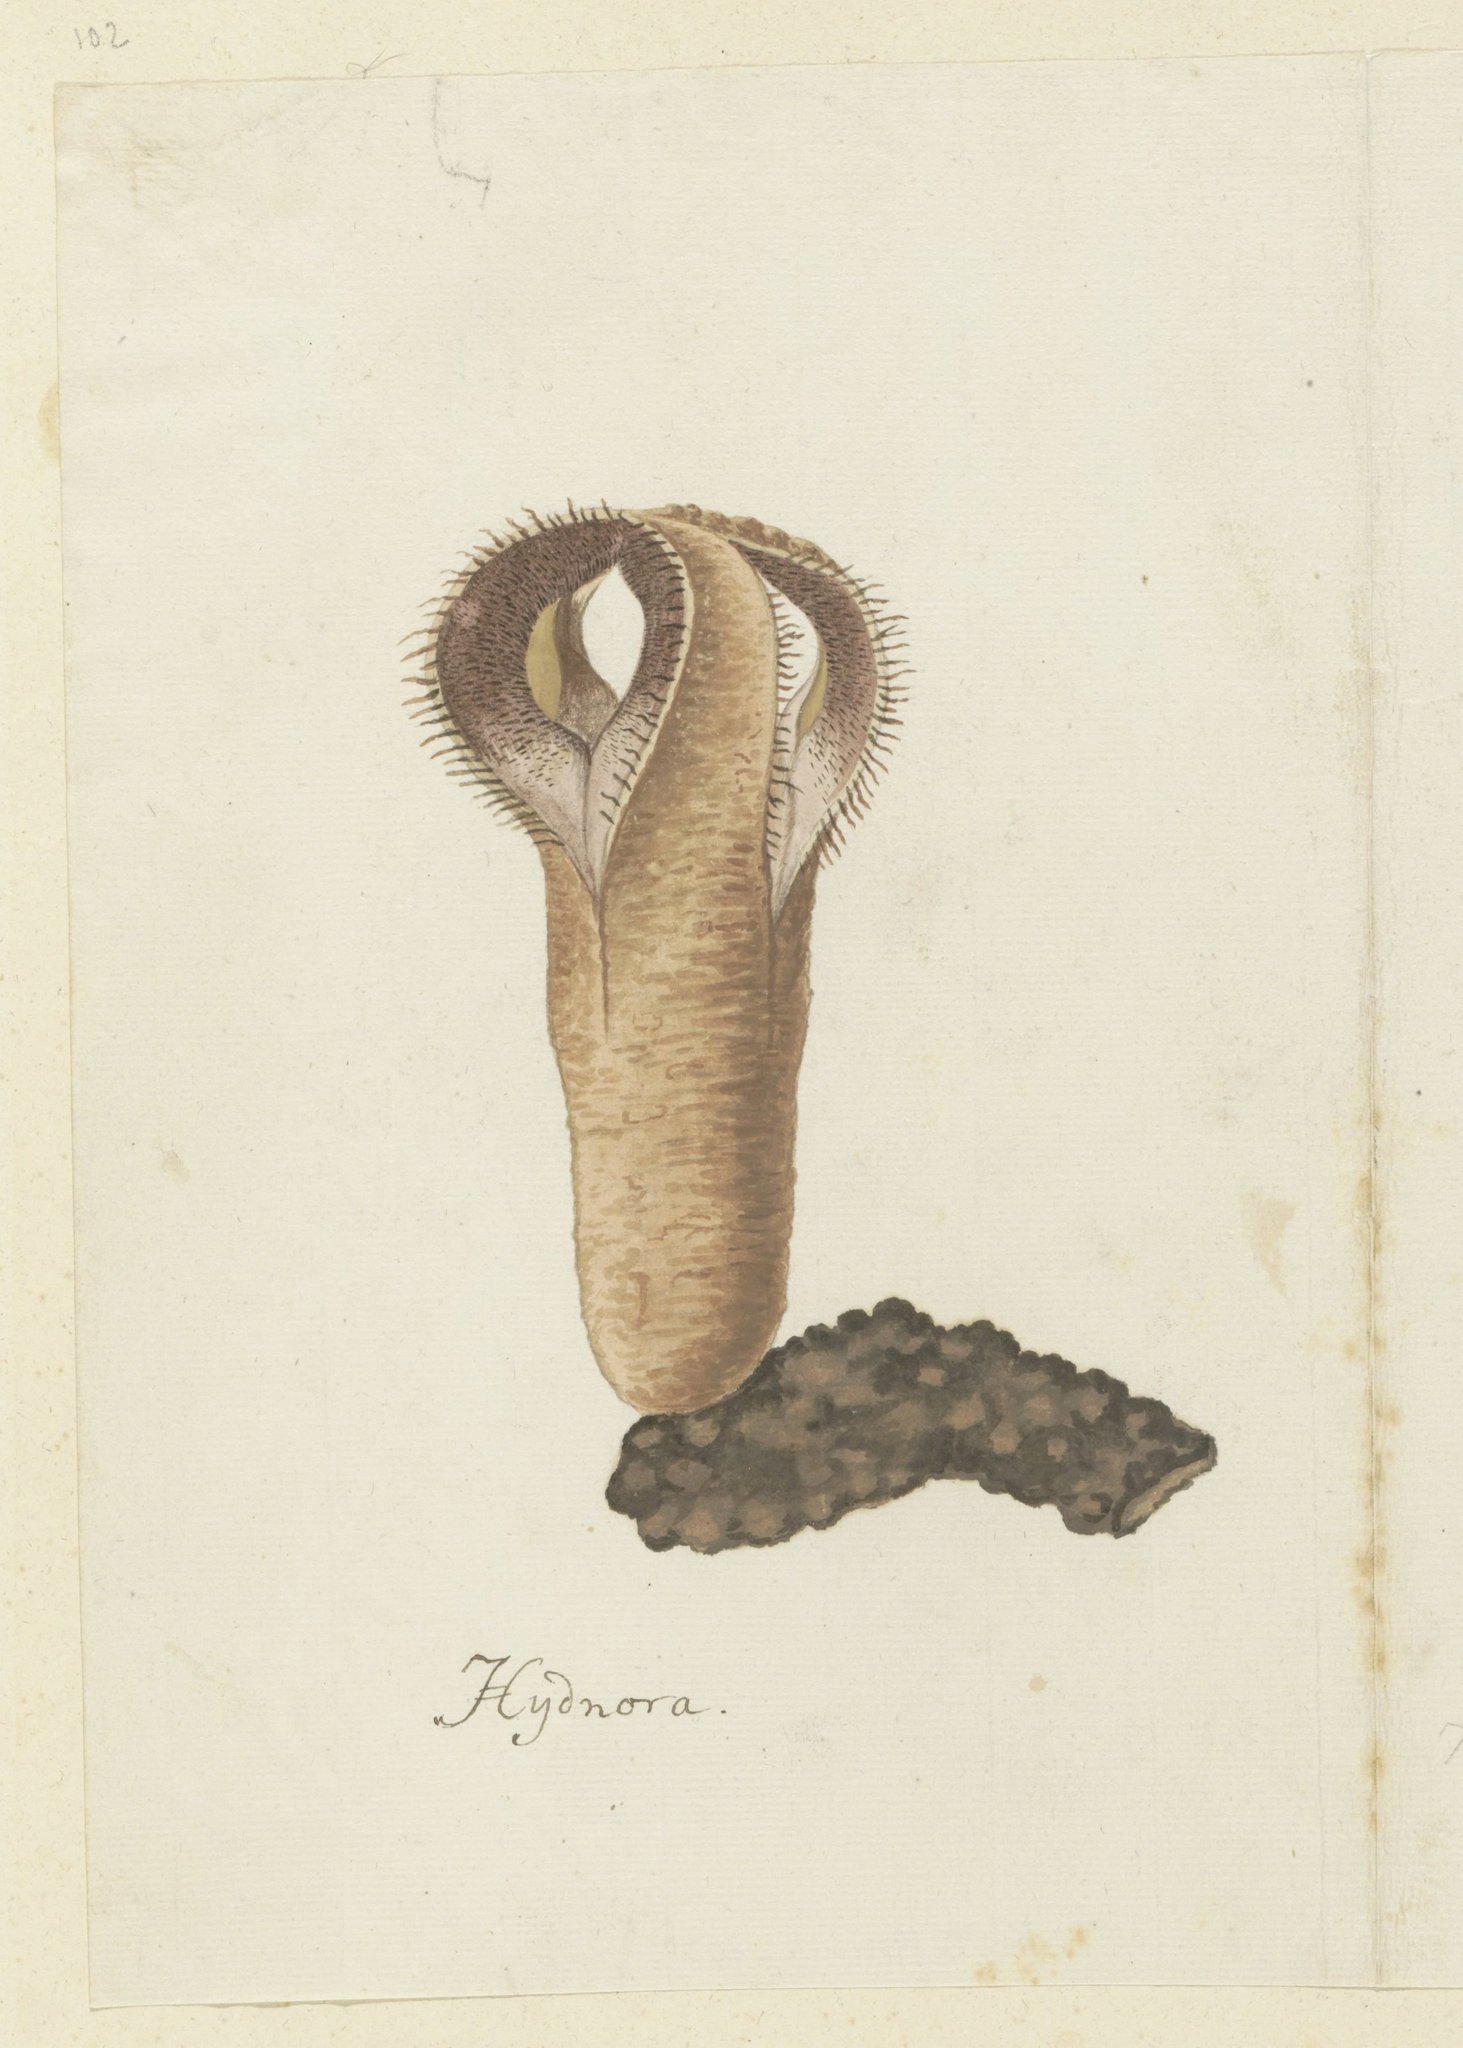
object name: album leaf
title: Hydnora africana Thunb. (Jackal-food plant)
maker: robert jacob gordon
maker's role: draughtsman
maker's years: 1743-1795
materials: chalk, ink, paper, pencil, watercolor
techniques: brush, pen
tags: plants; vegetation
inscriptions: annotation: ‘Hydnora’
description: De tekening is gemaakt voor of tijdens een van Gordon's vier expedities door de Kaapprovincie, van oktober 1777 tot maart 1786. Sommige (soort)namen kunnen zijn gewijzigd, gezien reorganisatie in plantentaxonomie gedurende de afgelopen jaren.